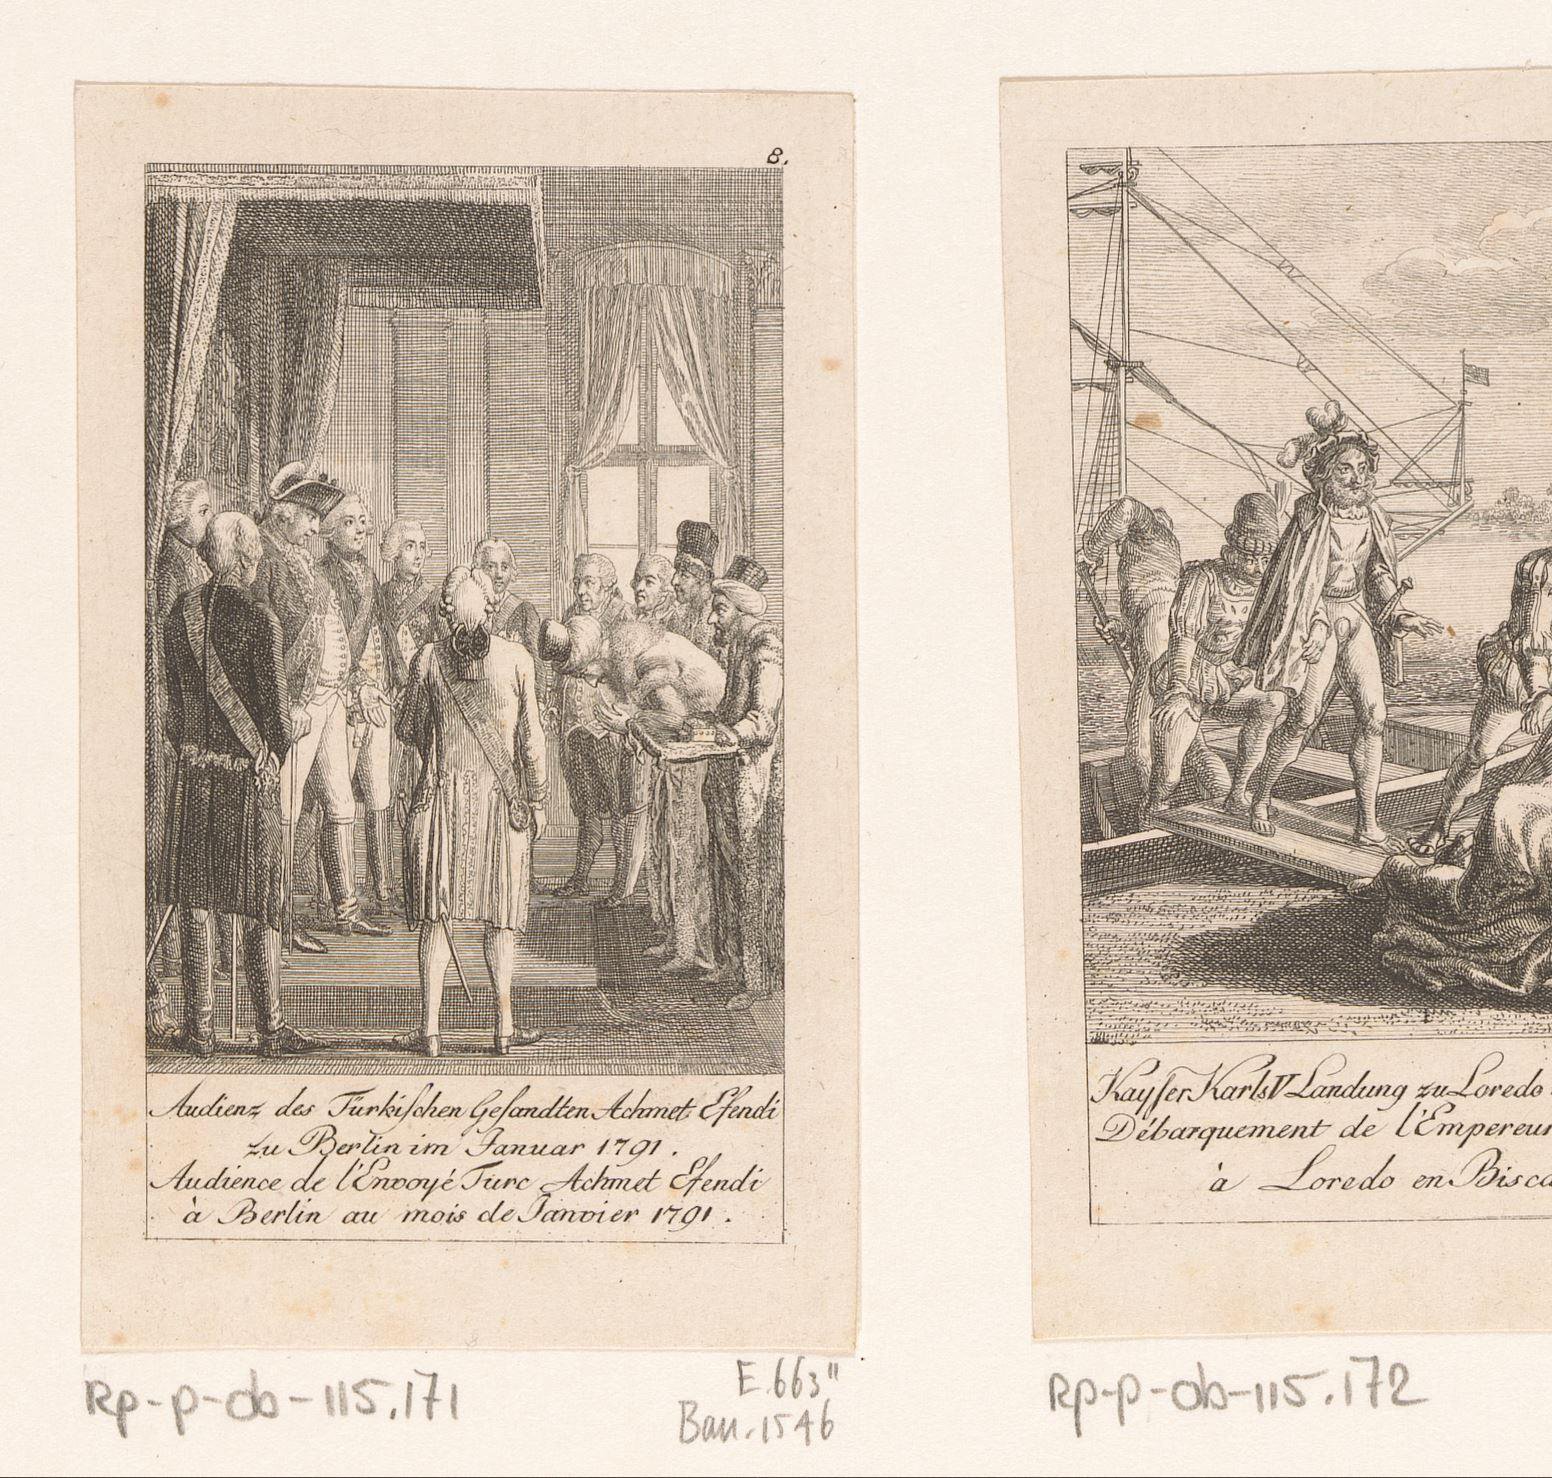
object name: book illustration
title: Ahmed Efendi op audiëntie bij Frederik II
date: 1791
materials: paper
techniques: etching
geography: berlin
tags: politician, asiatic races and peoples: turks, history, audition; ruler giving audience, berlin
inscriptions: collector's mark: Lugt 2228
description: Prent gebruikt voor: Gothaischer Hof Kalender, zum Nutzen und Vergnügen auf das Jahr 1792. Gotha: C. W. Ettinger, [1791].